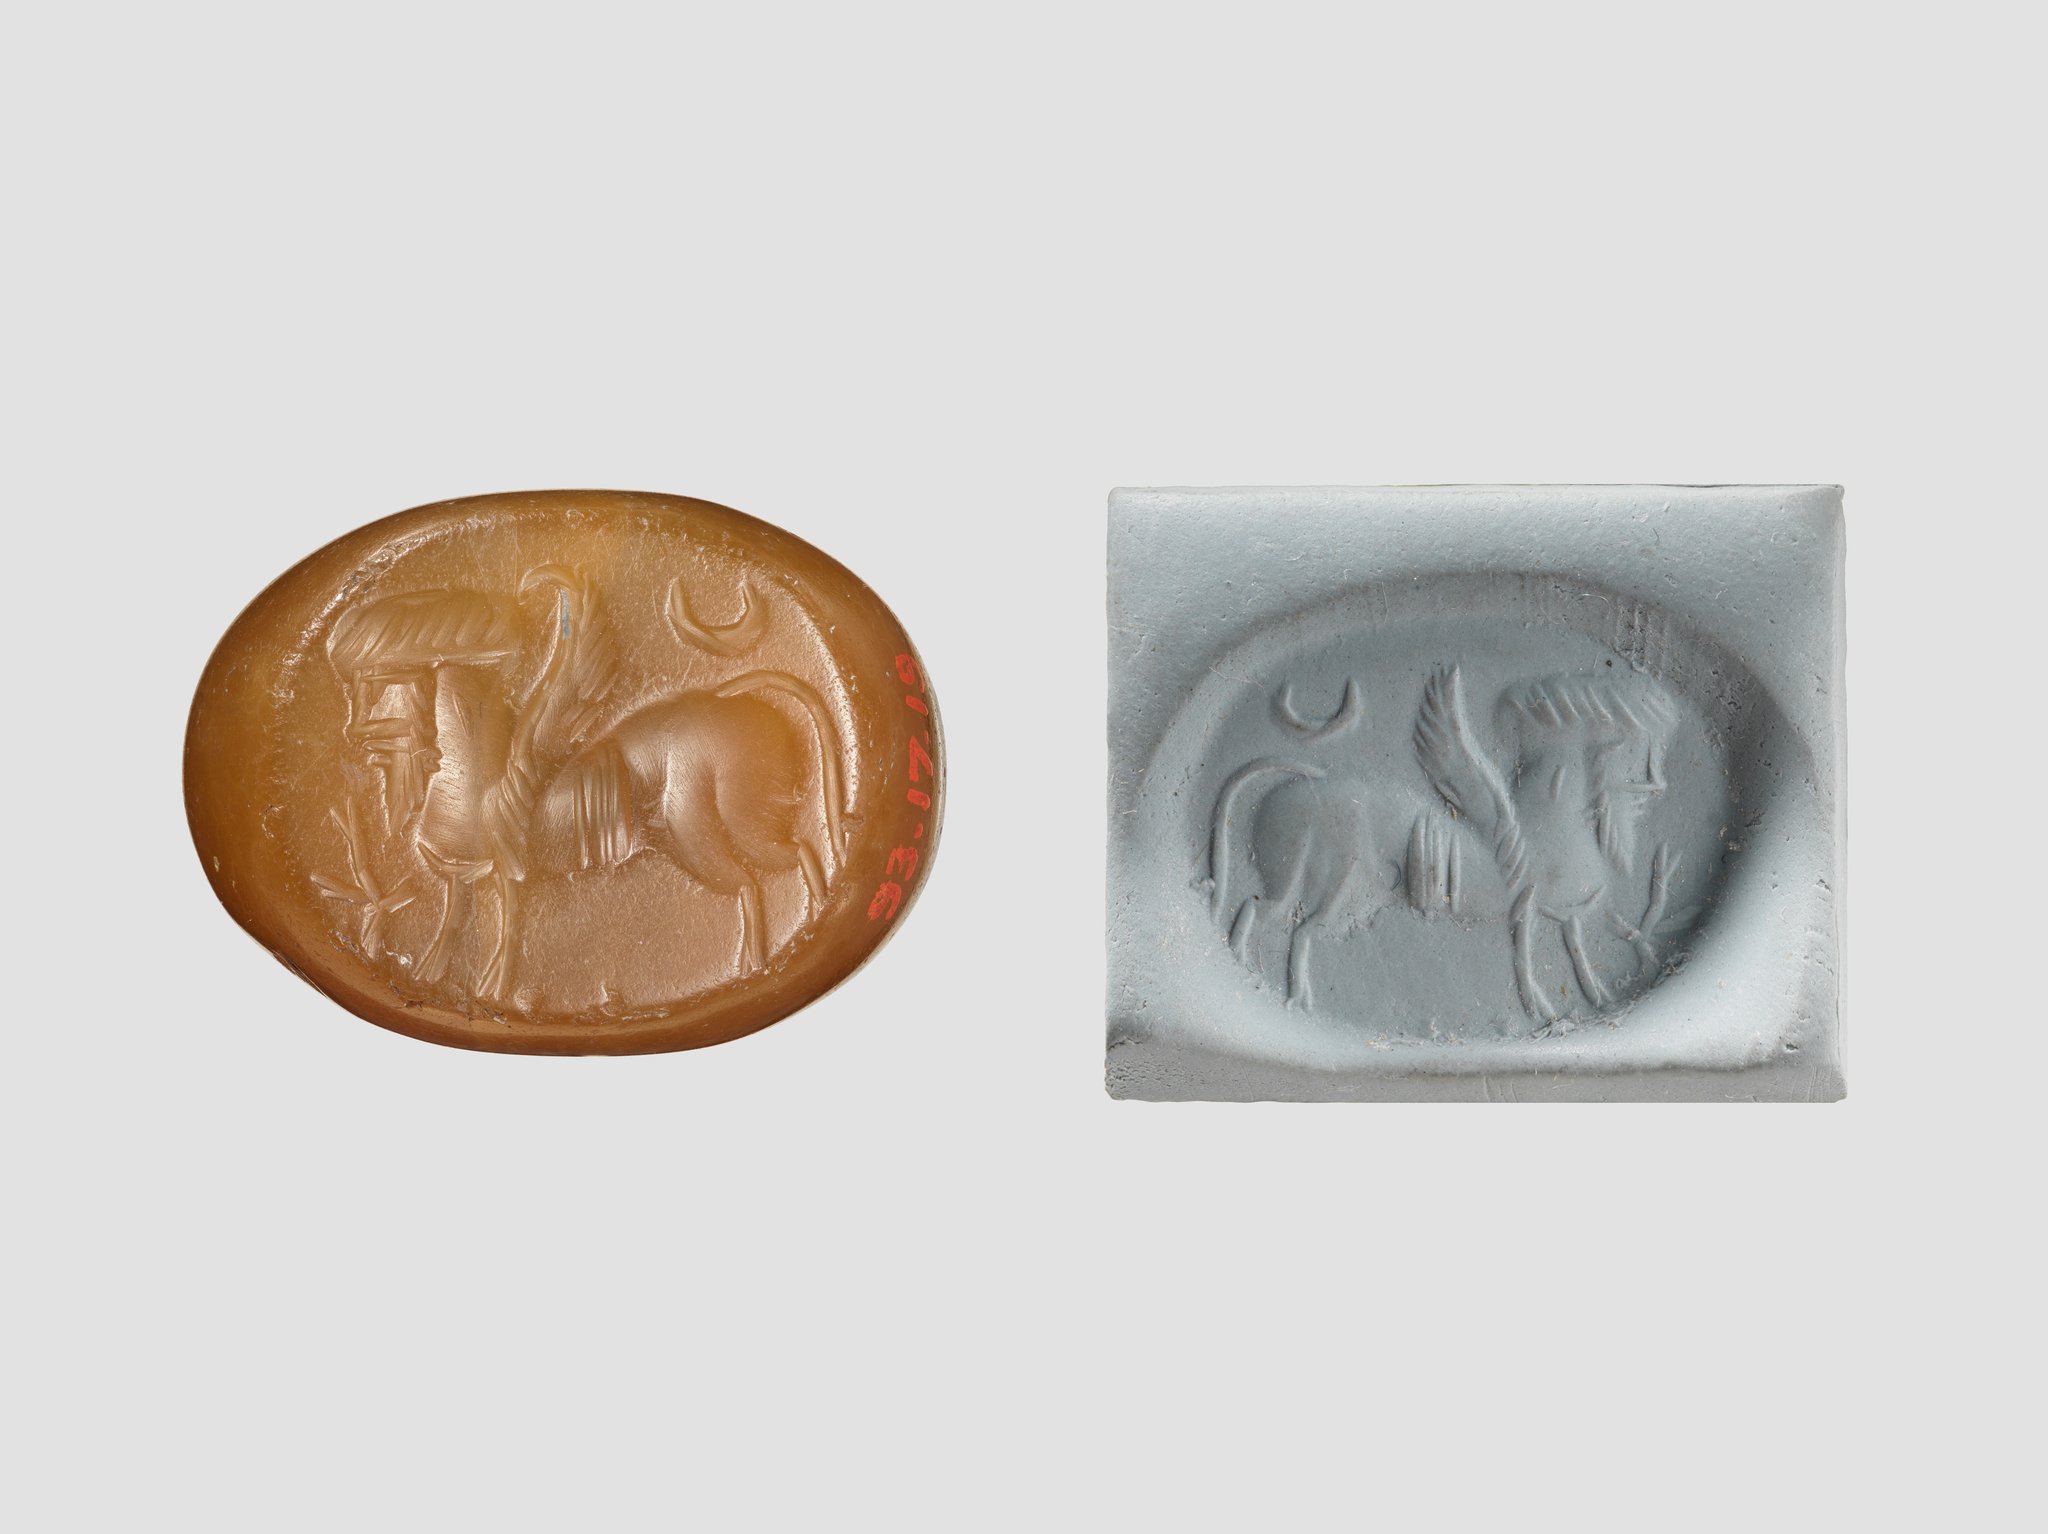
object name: stamp seal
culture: sasanian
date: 201-700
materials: stone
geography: iran or mesopotamia